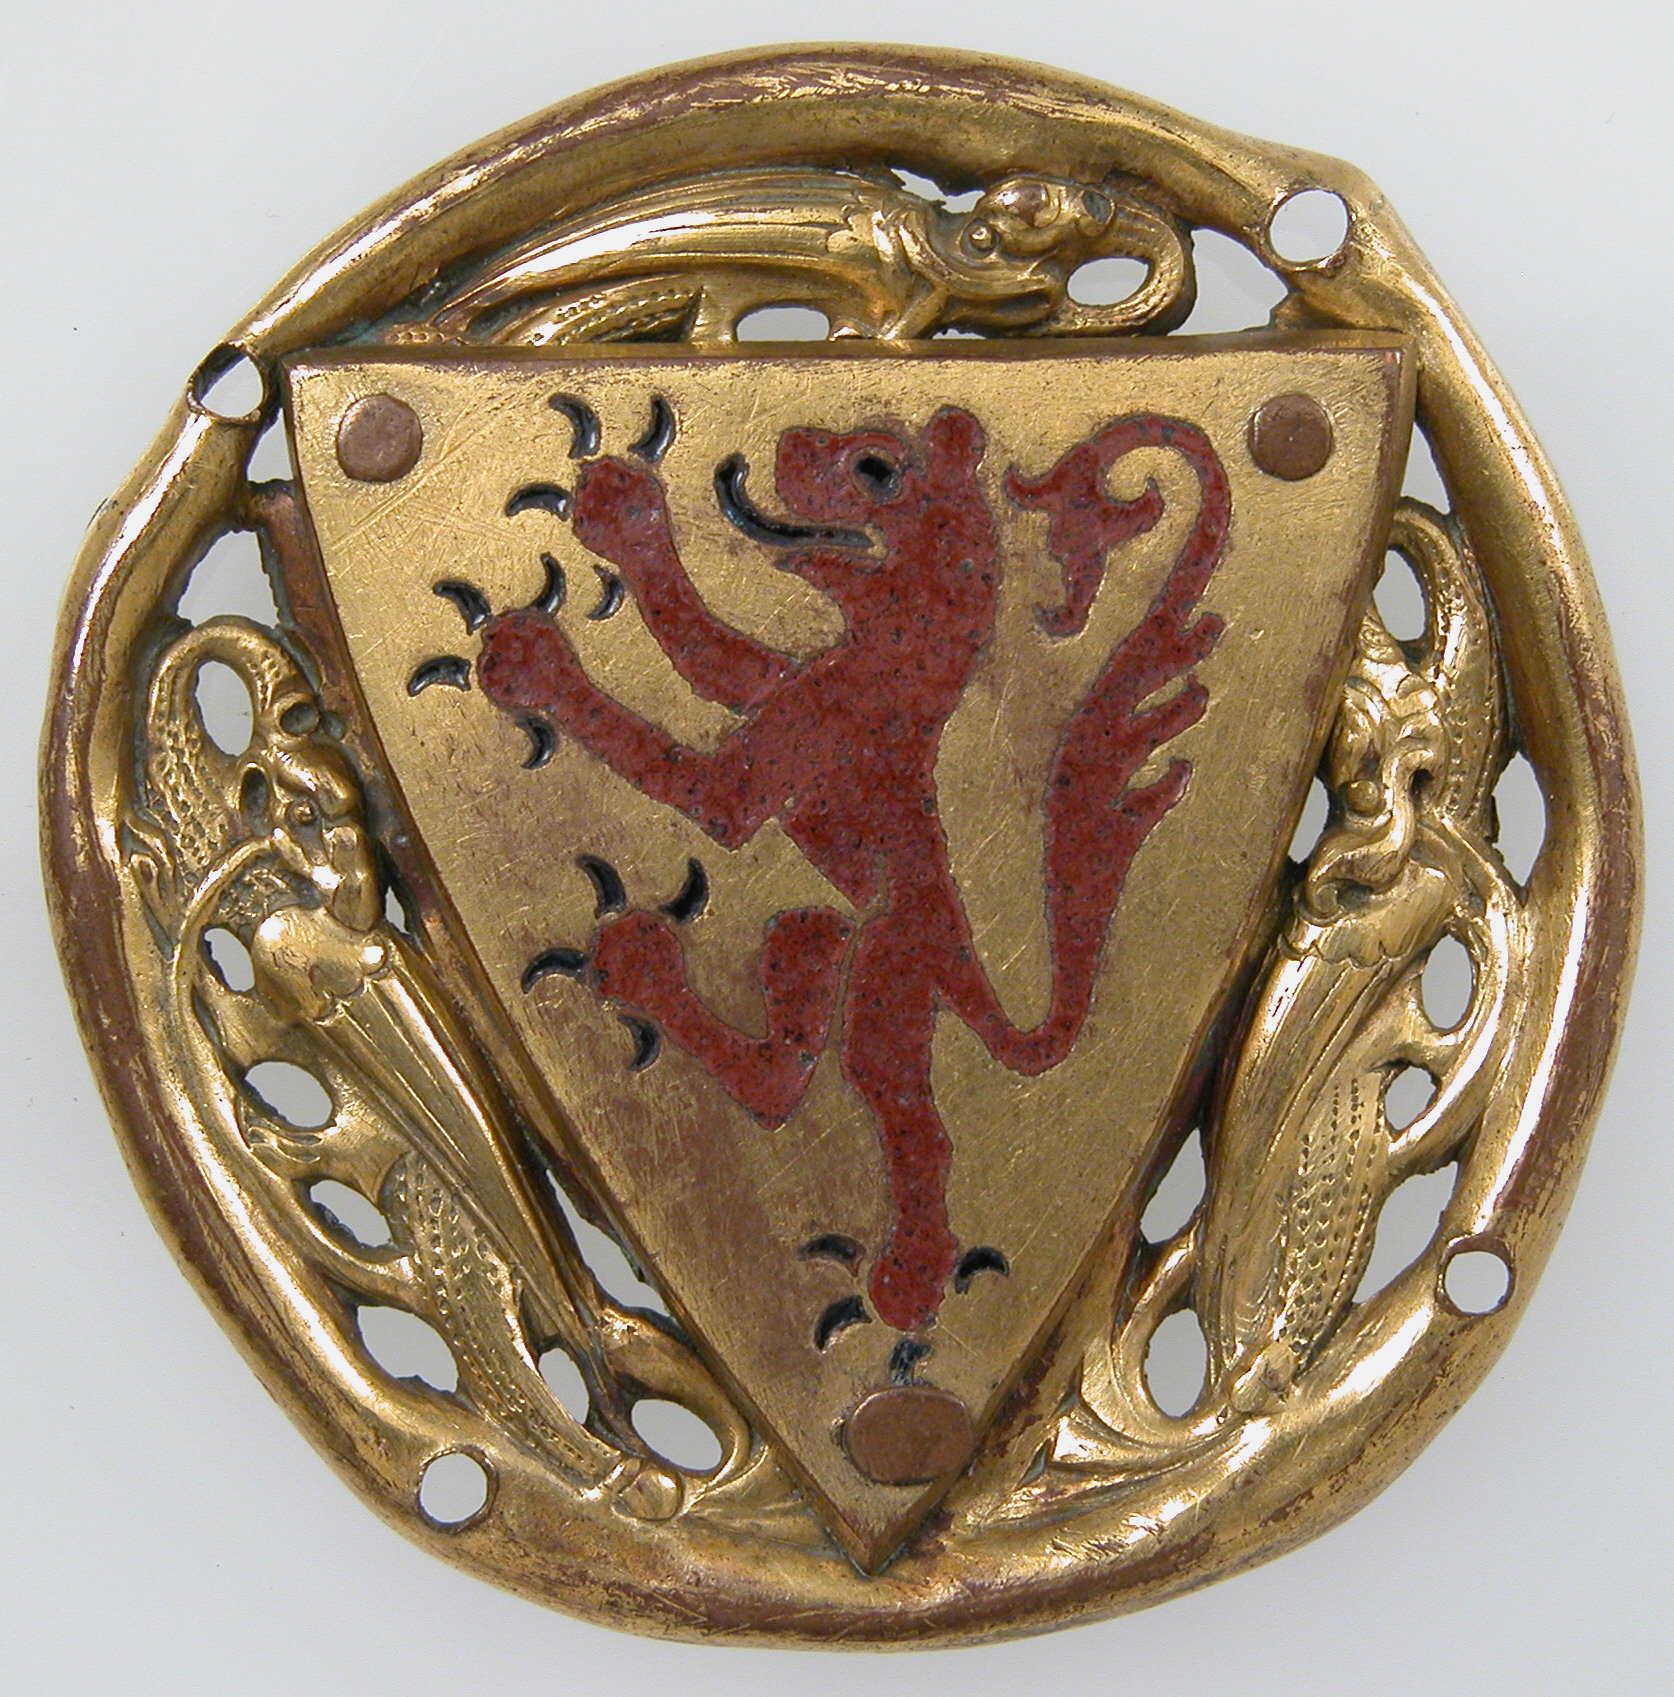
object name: roundel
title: Armorial Roundel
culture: french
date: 1801-1900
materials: gilt copper, enamel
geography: france